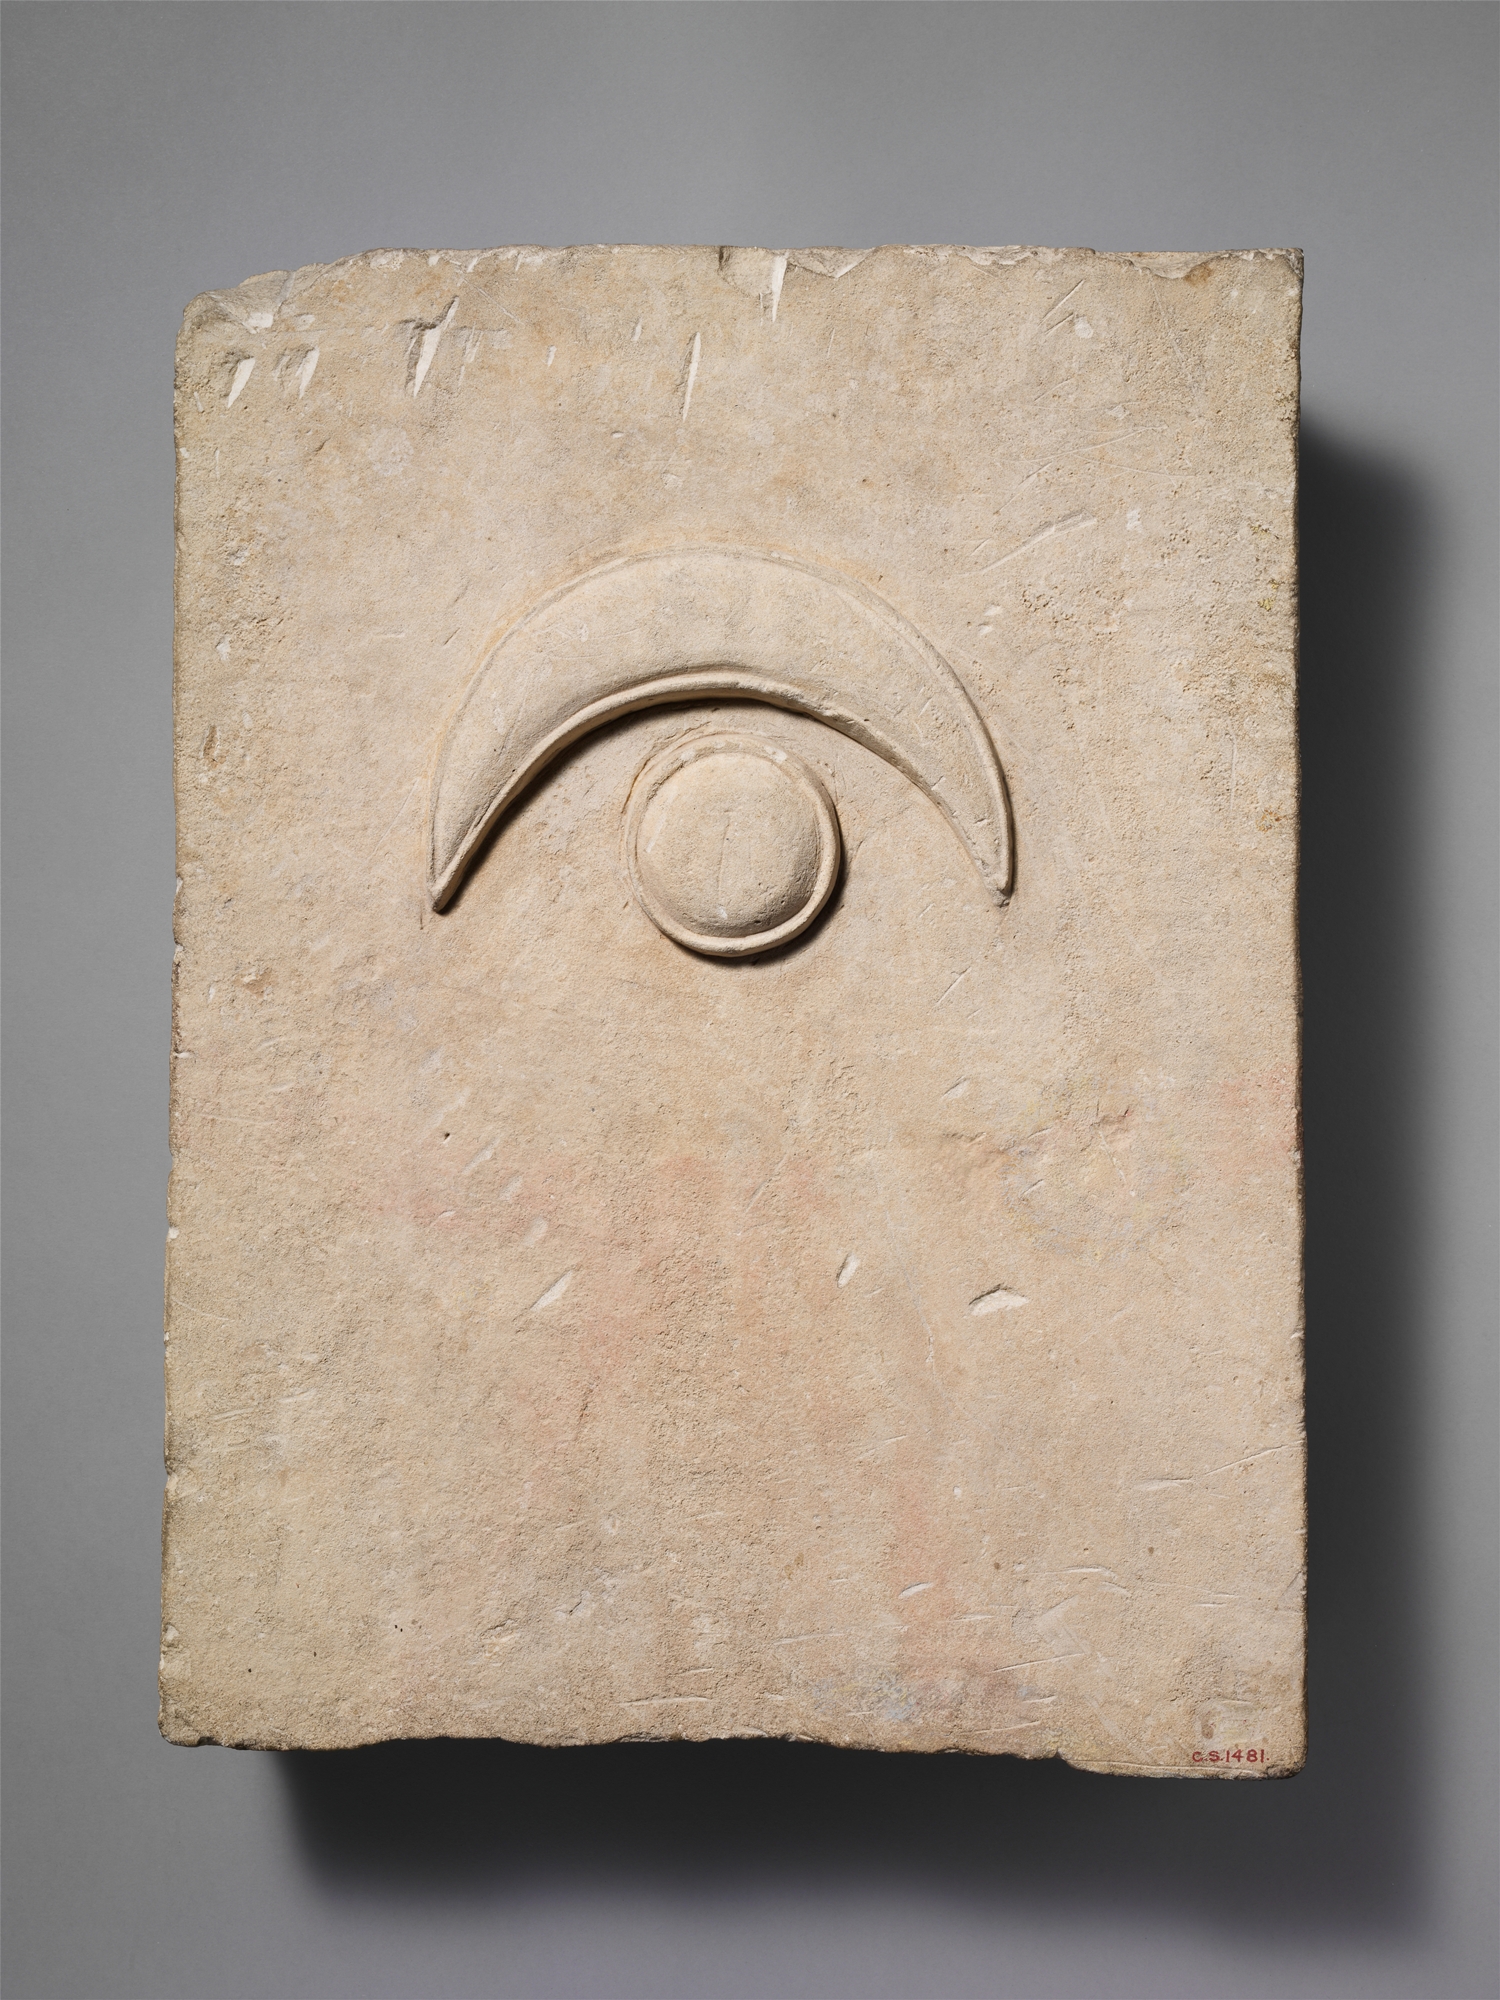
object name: grave stele with crescent and disk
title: Fragment of a limestone funerary stele with a disk and a crescent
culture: cypriot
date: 550-501 BCE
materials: limestone